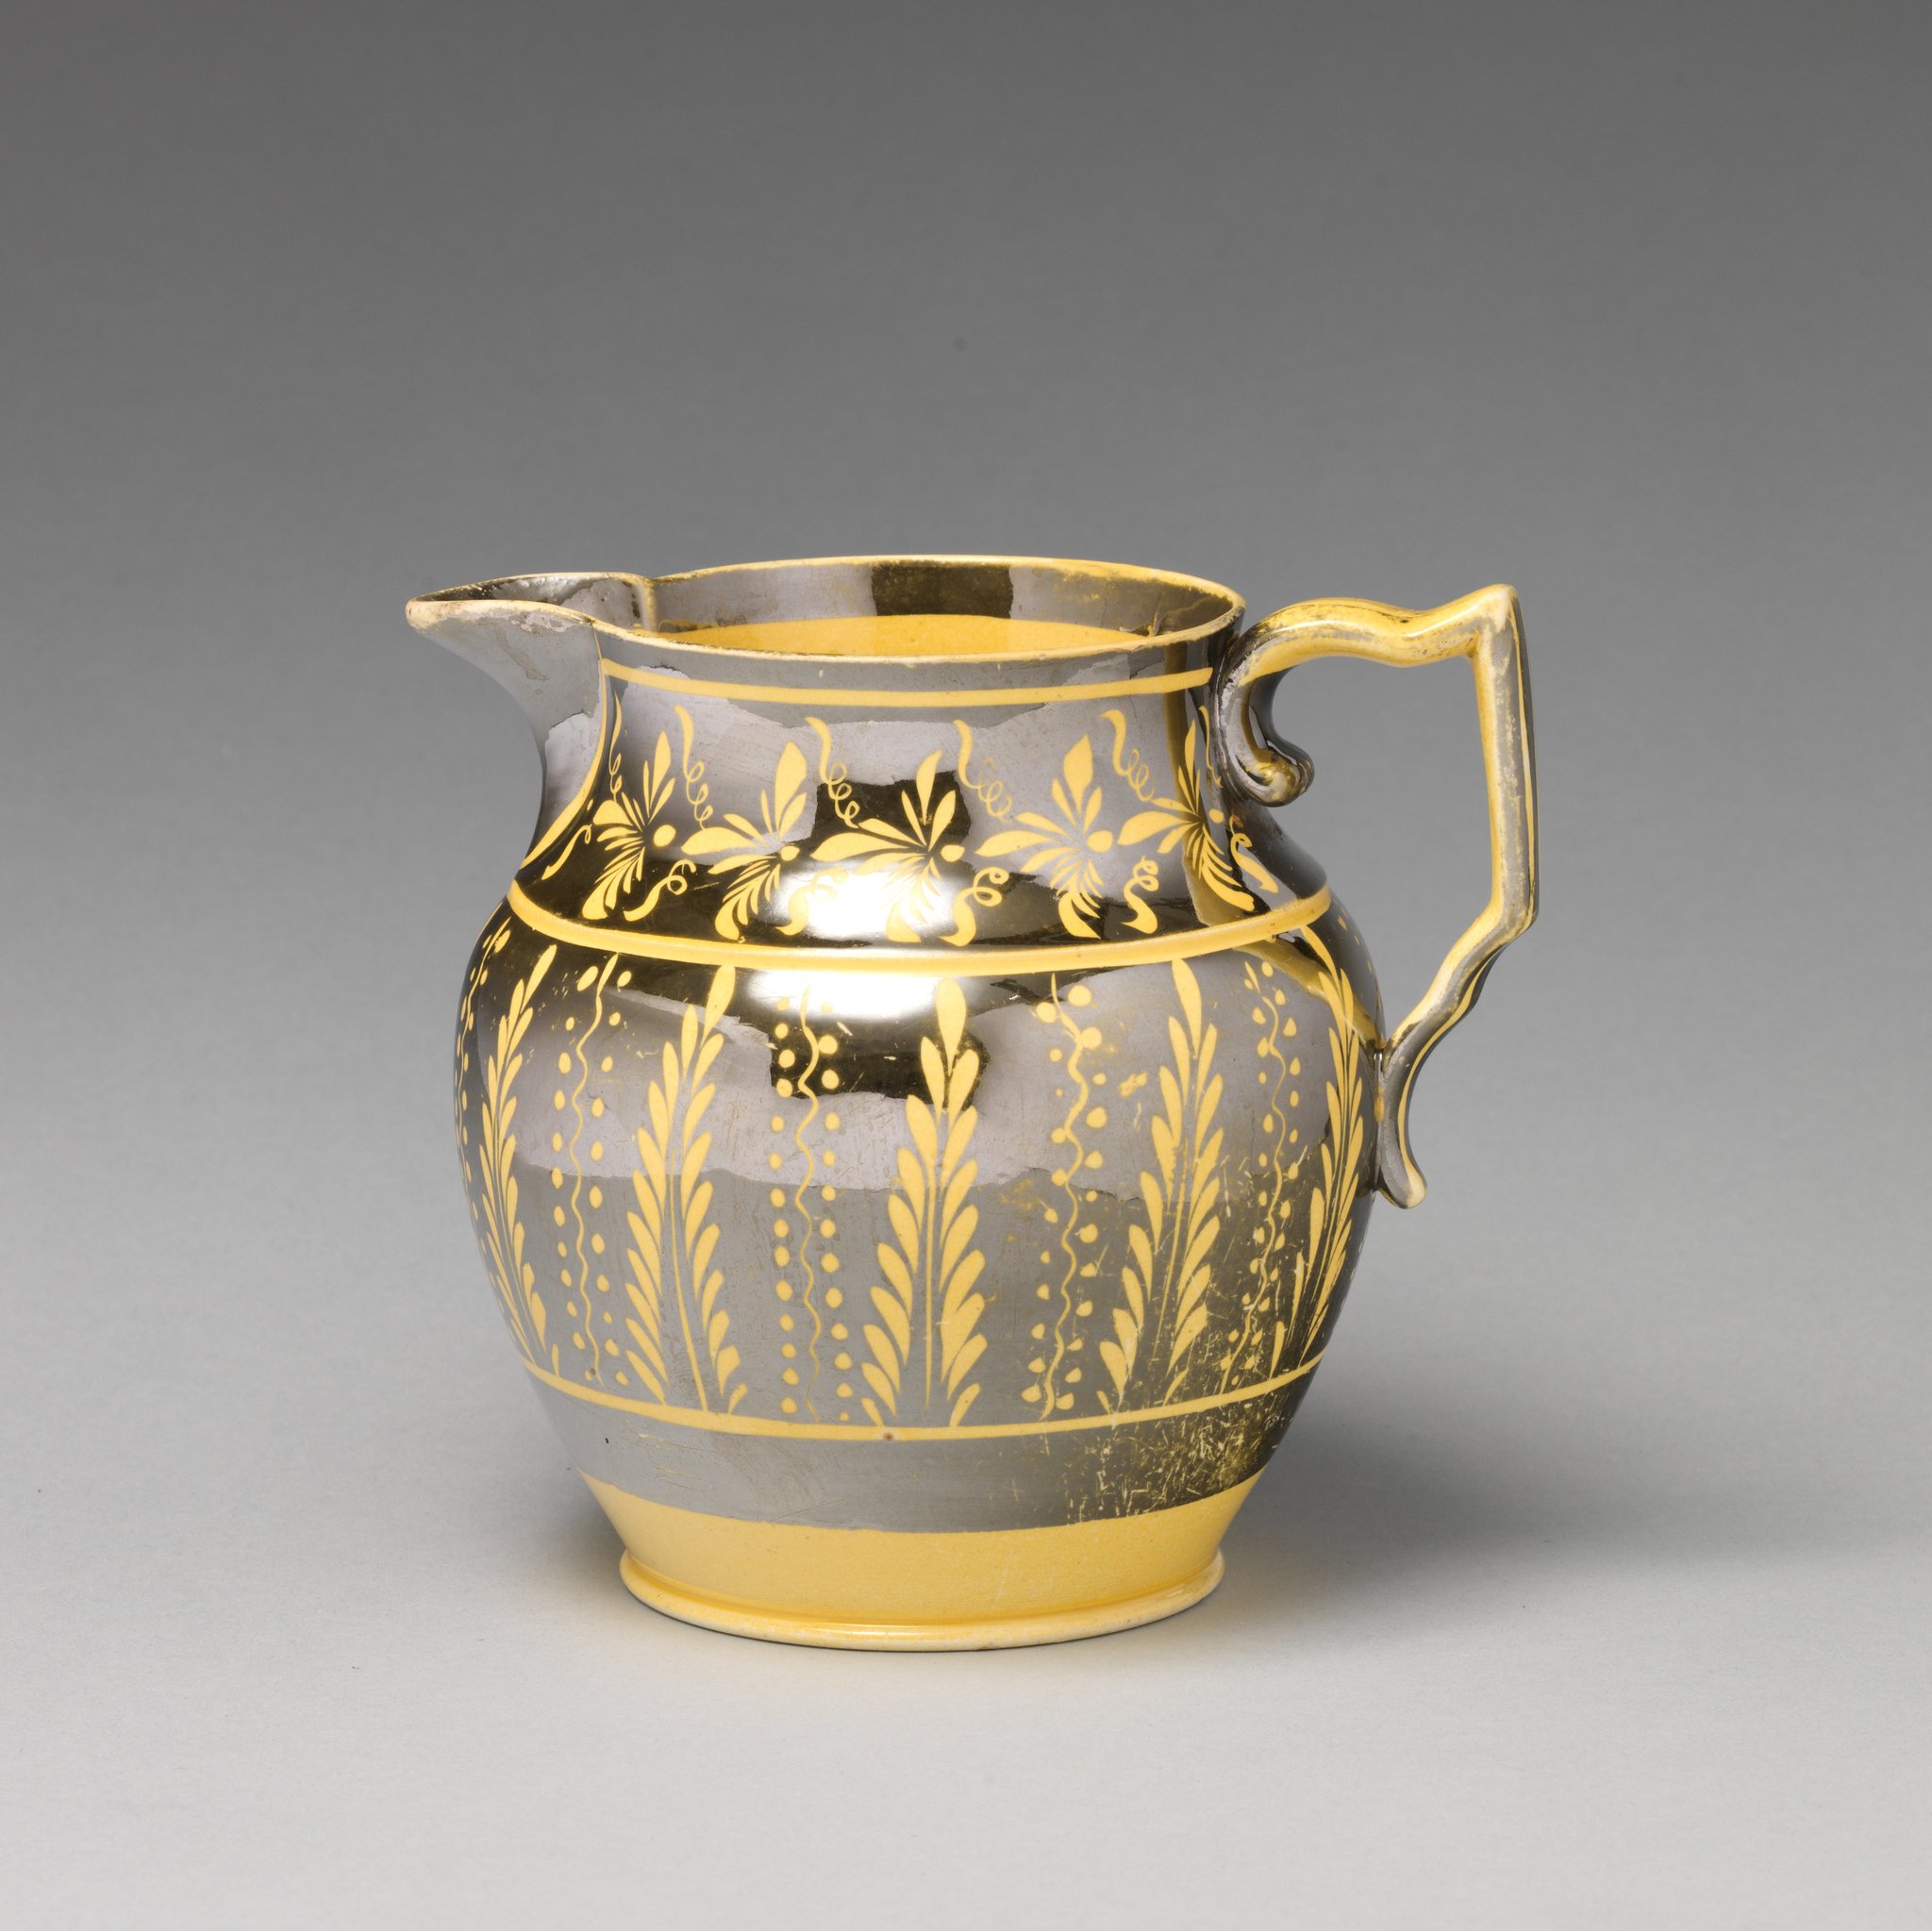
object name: jug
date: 1815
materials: earthenware